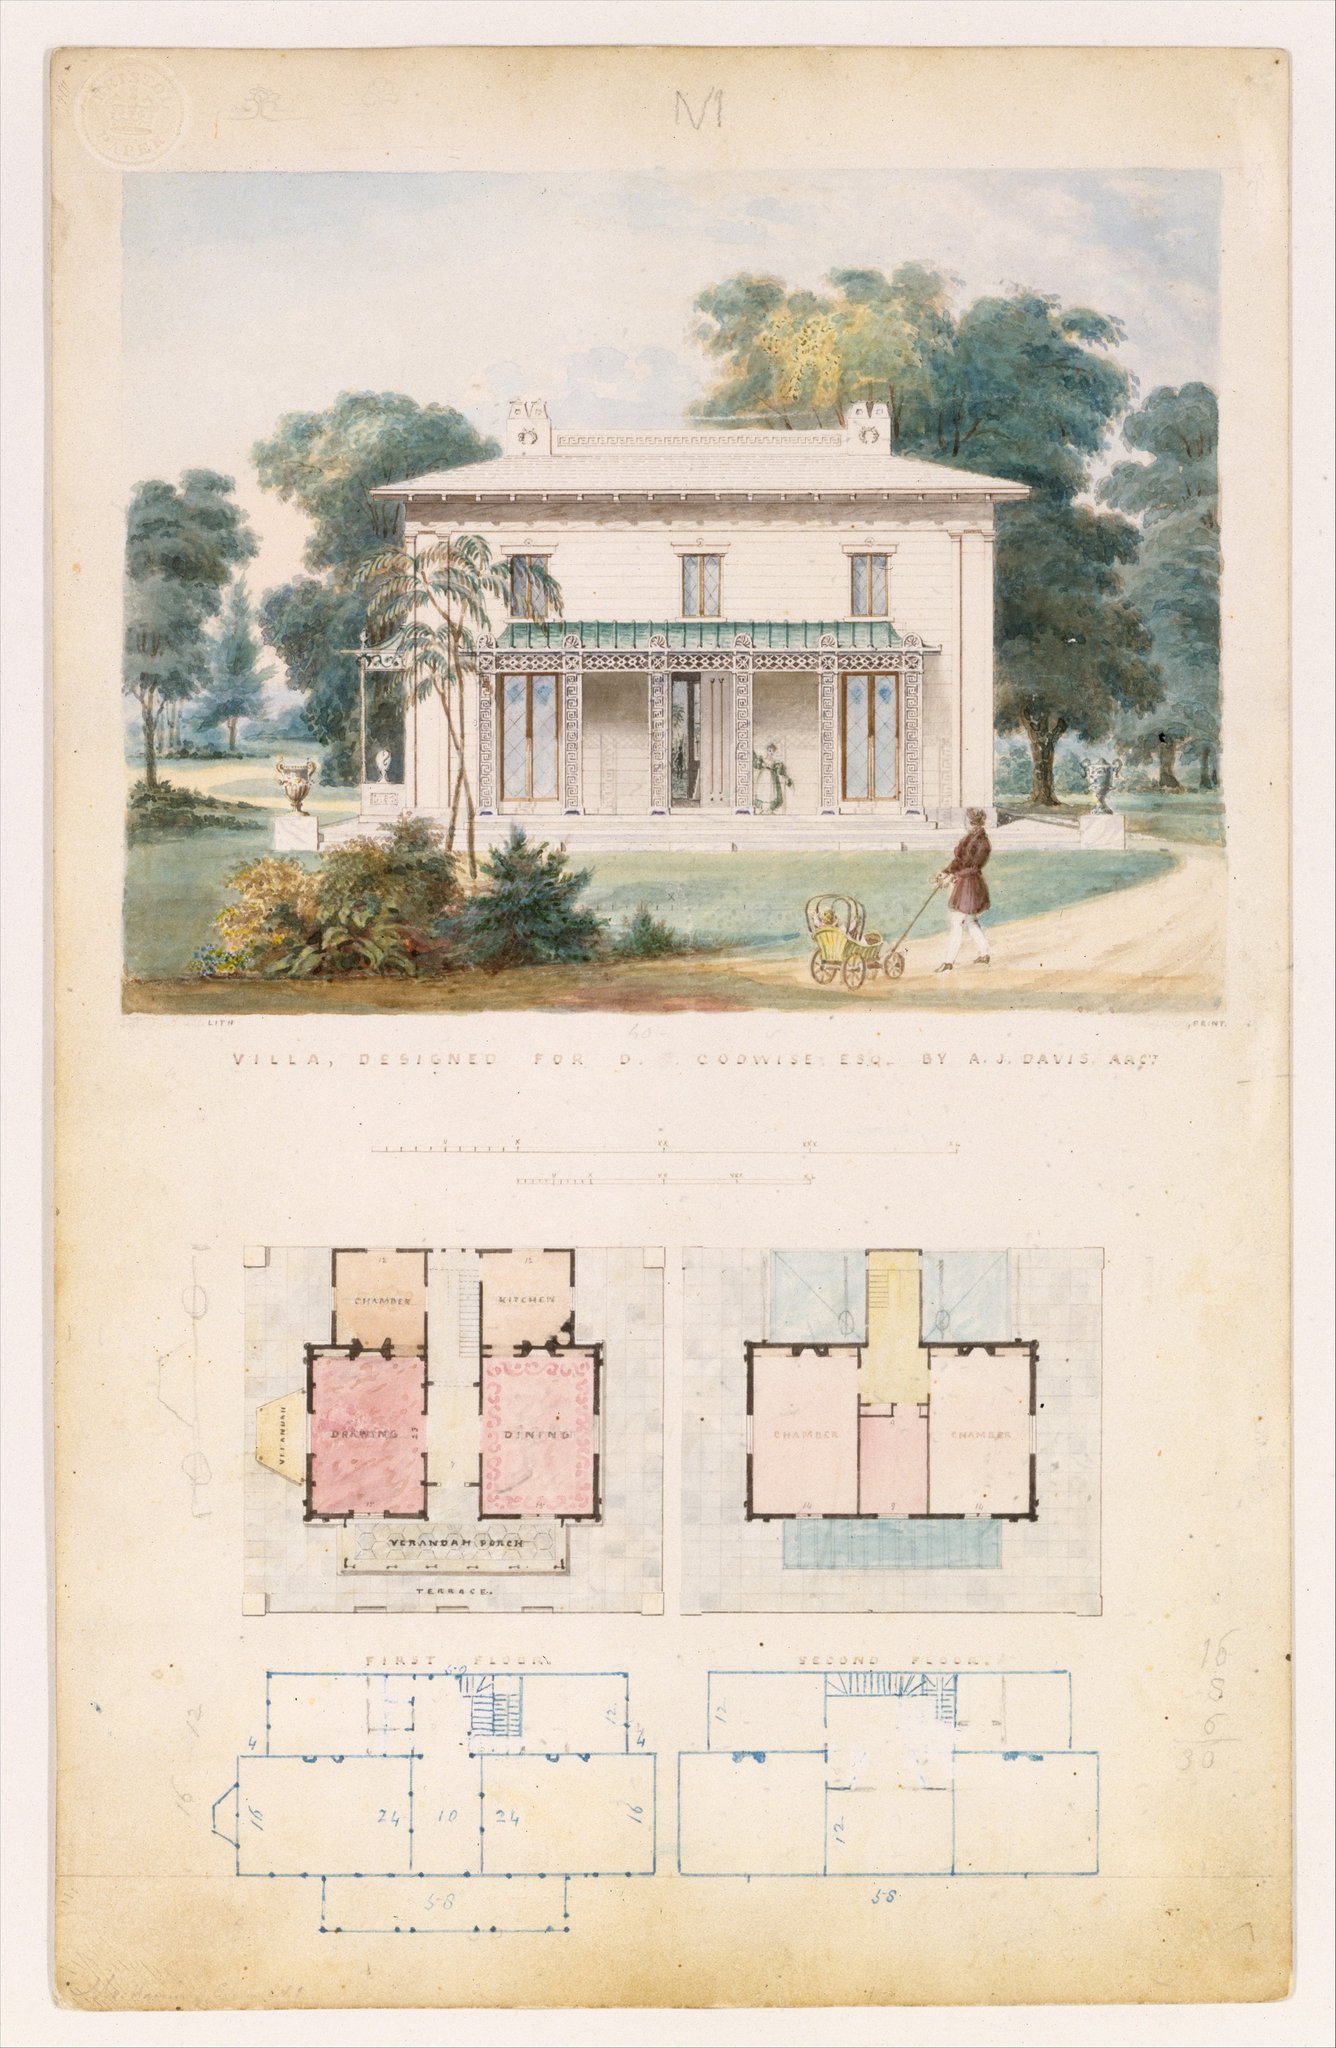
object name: drawing ornament architecture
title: Villa for David Codwise, near New Rochelle, NY (project; elevation and four plans)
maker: alexander jackson davis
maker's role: artist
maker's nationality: american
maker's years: 1803-1892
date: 1835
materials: graphite, ink, watercolor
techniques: pen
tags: architecture,houses